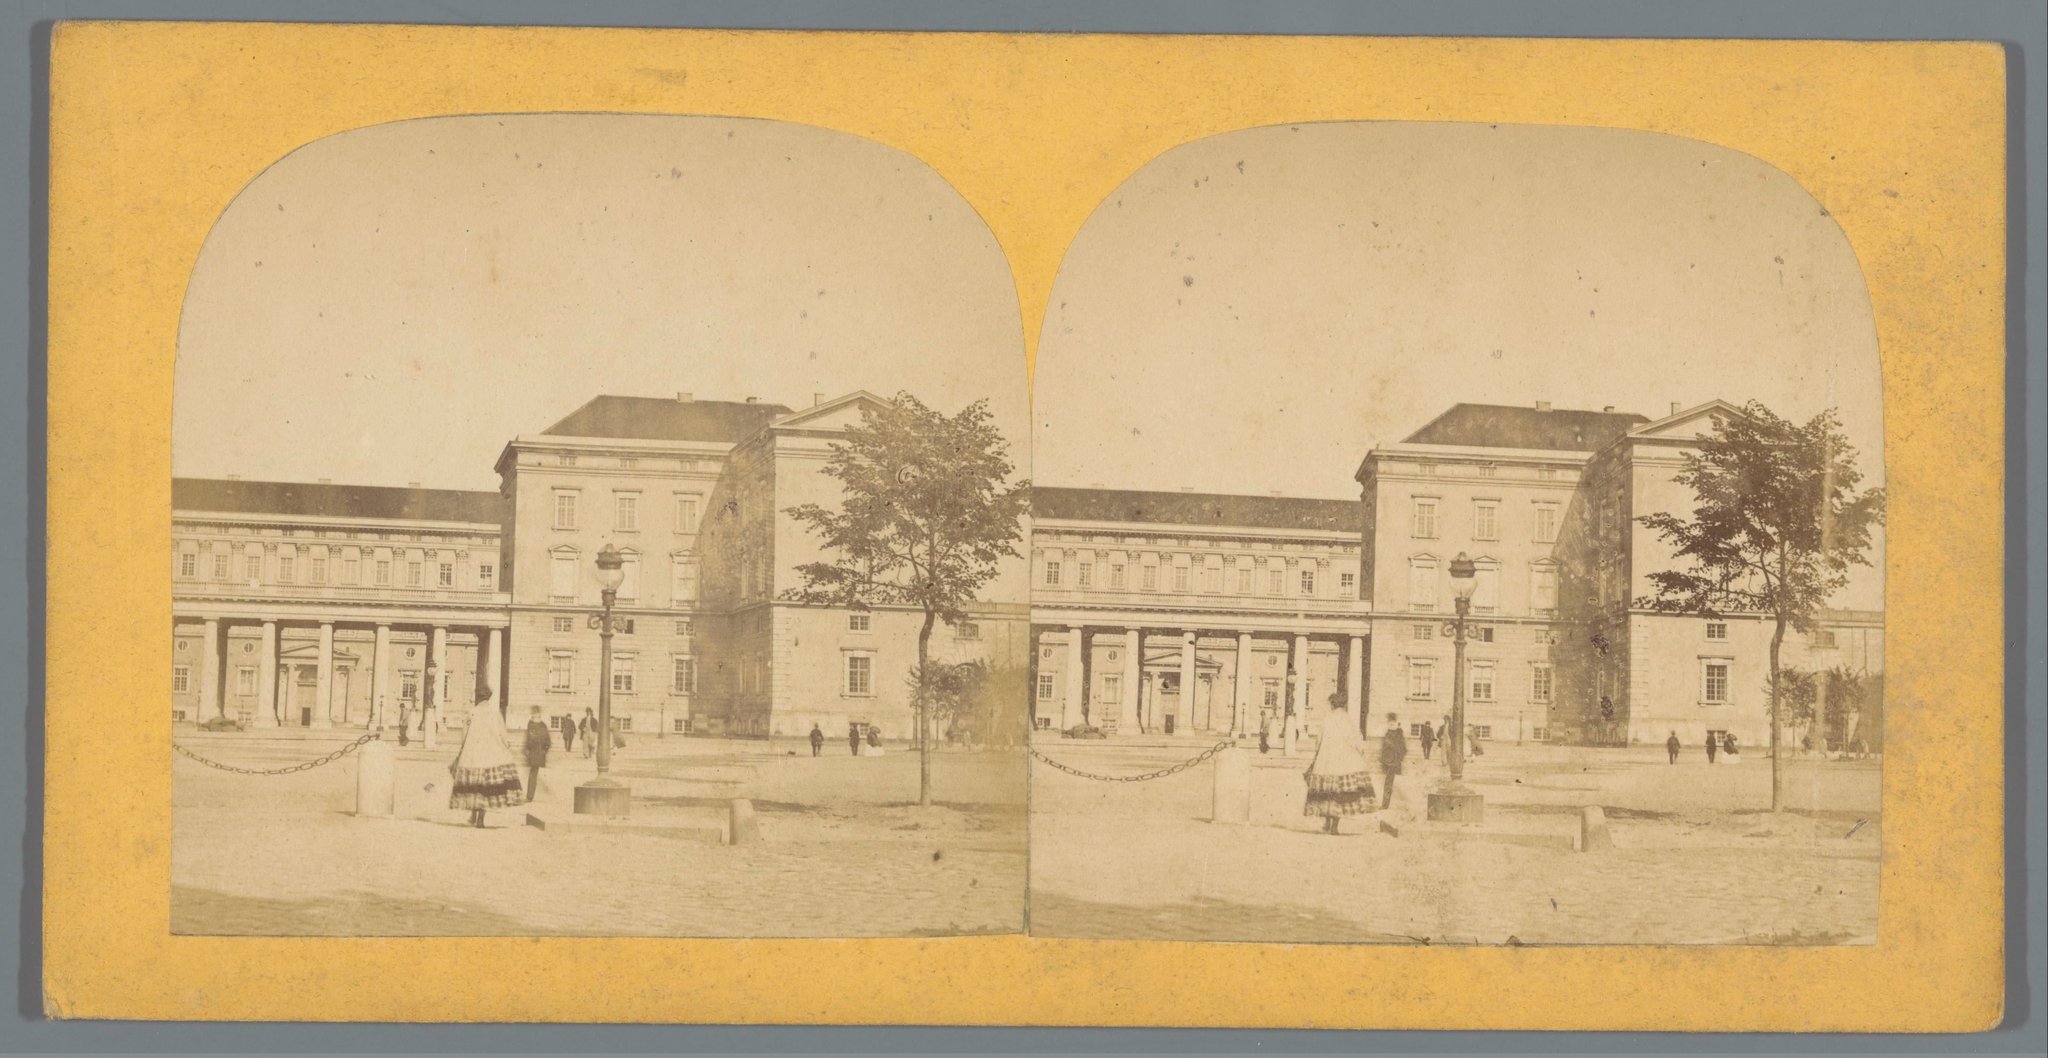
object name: stereograph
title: Christiansborg Slot, Kolonnaden / Vue du château de Christiansborg, la colonnade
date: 1862-1884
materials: cardboard, paper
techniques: albumen print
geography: copenhagen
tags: palace, lower house, parliament, chamber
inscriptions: inscription: ‘Brevete Eneret’, address: ‘FOTOGRAFISK INSTITUT/ Budtz Müller & Co./ Bredgade No. 21, Kjöbenhavn.’, number: ‘67.’